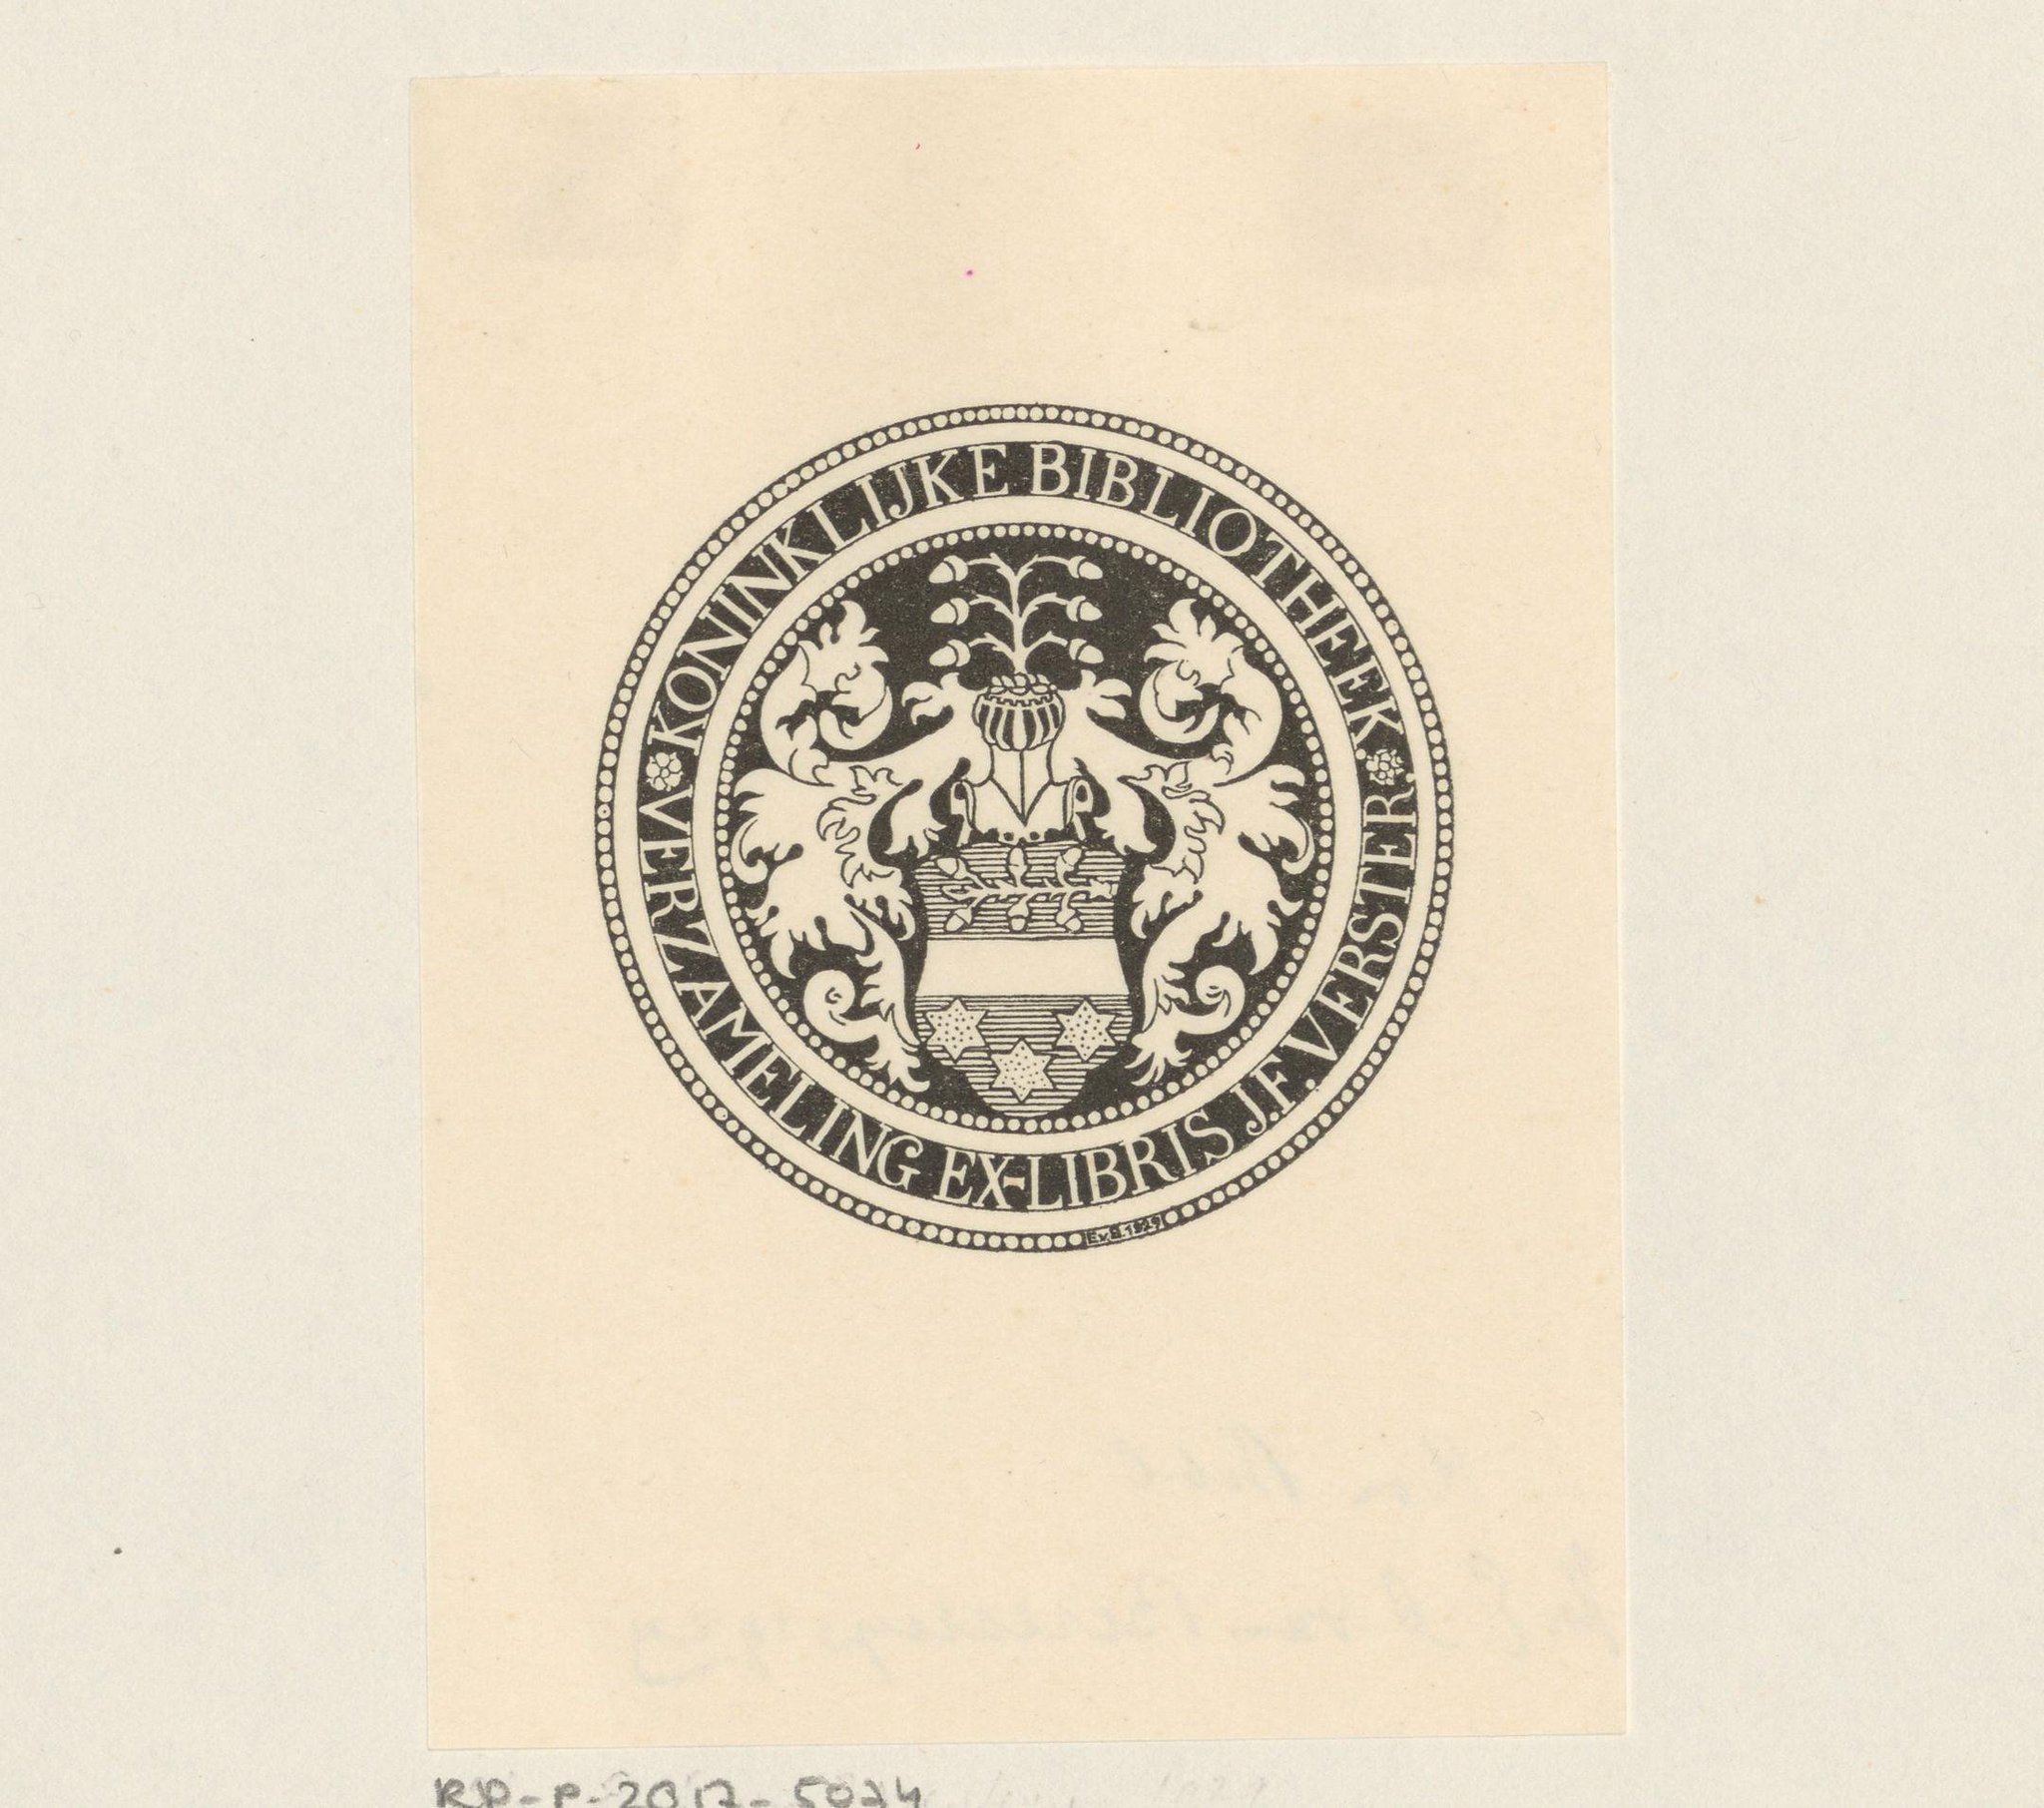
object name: bookplate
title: Eigendomsmerk van de Koninklijke Bibliotheek Verzameling ex-libris J.F. Verster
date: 1929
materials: paper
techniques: printing block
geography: netherlands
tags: armorial bearing, heraldry, fruits: acorn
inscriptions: date